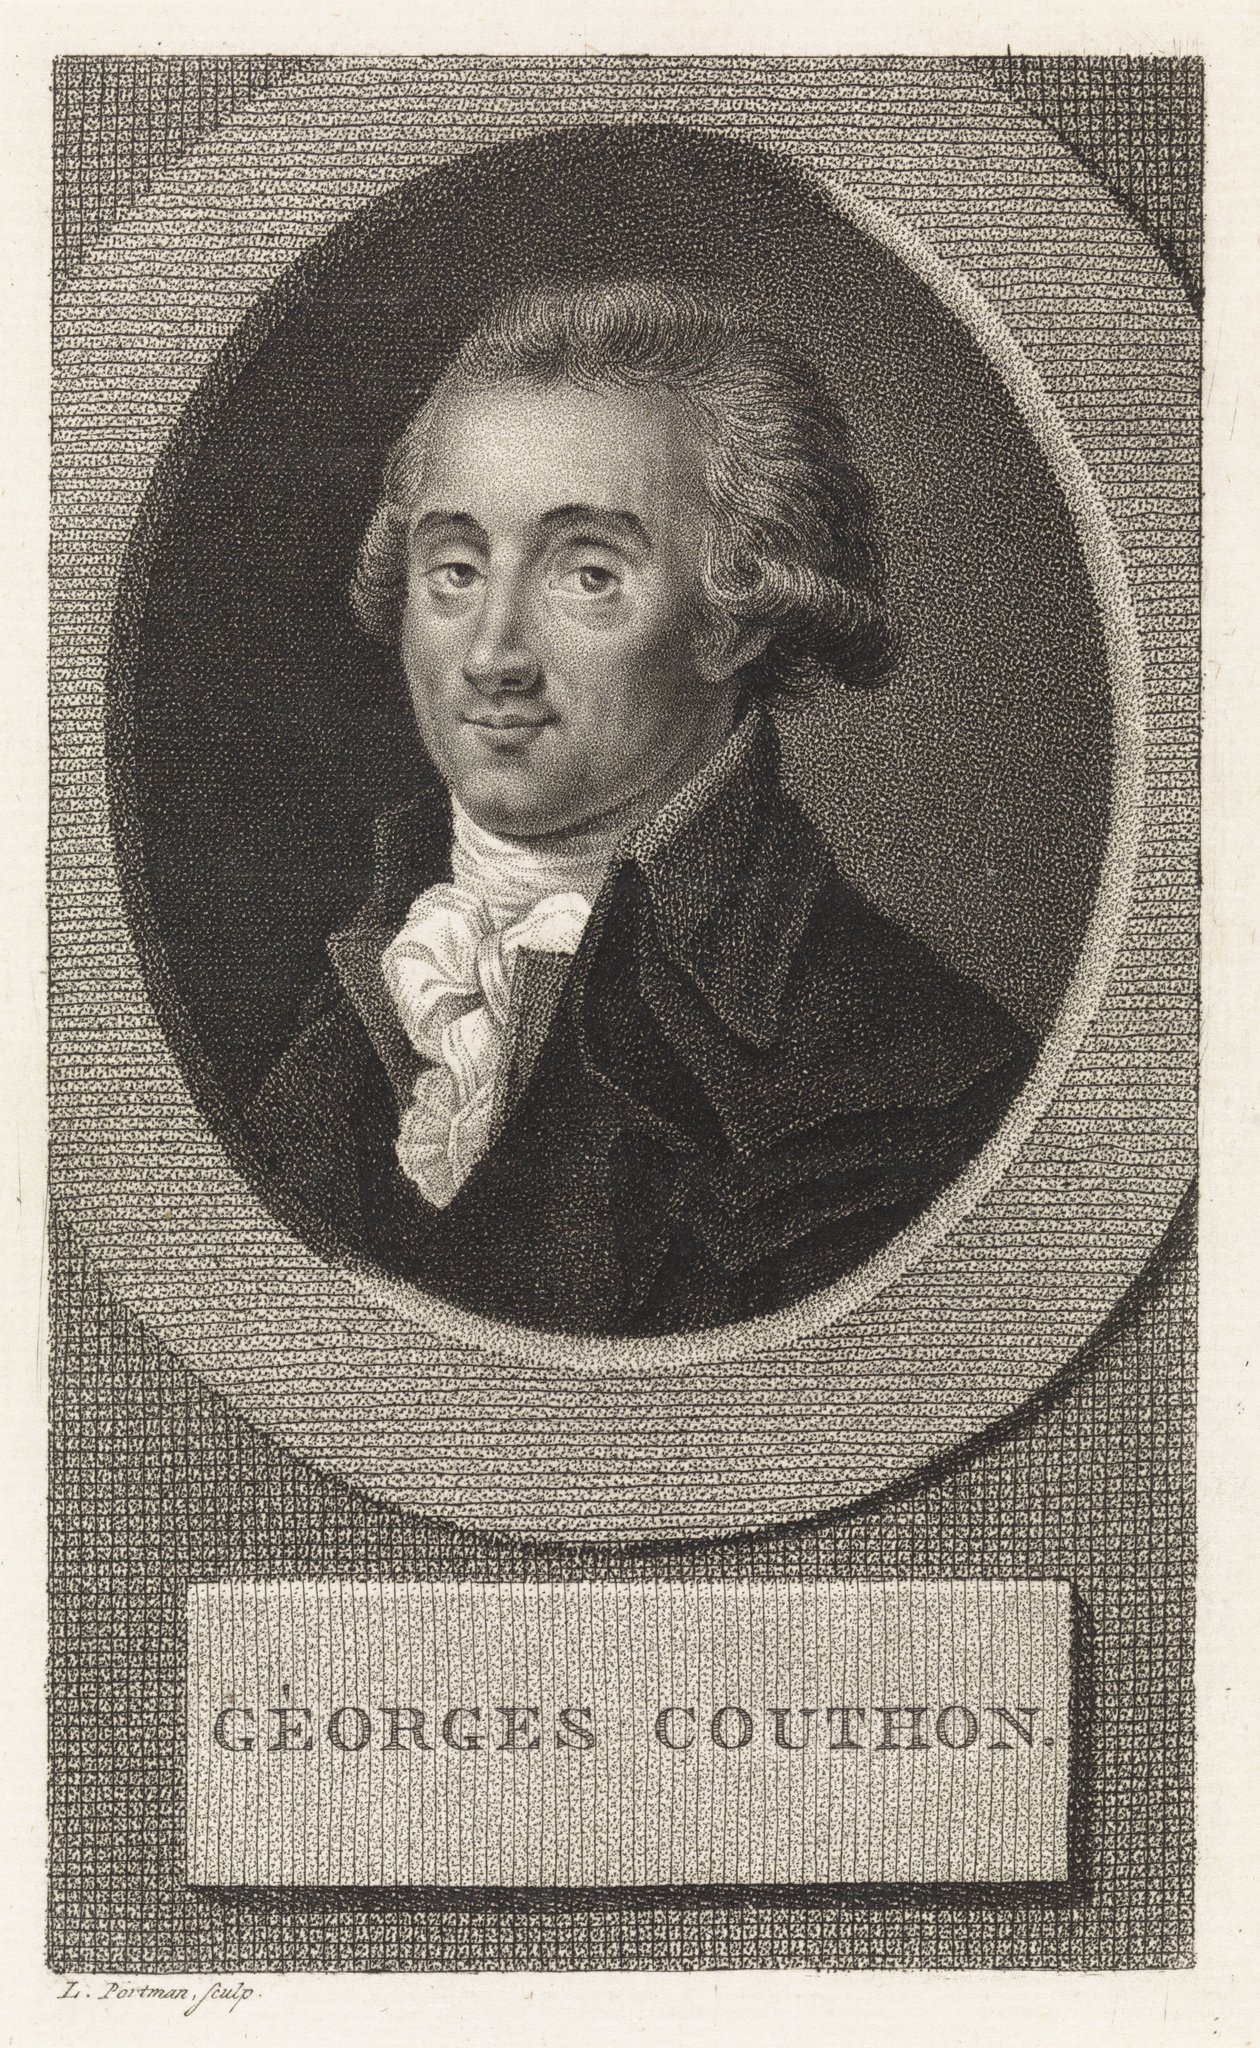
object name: print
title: Portret van Georges Auguste Couthon, Franse politicus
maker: ludwig gottlieb portman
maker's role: print maker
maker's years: 1772-1828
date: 1804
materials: paper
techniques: stippled etching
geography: amsterdam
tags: advocaat, georges auguste couthon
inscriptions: collector's mark: Lugt 2228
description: Prent ook gebruikt als illustratie in: Tafereelen van de staatsomwenteling in Frankrijk, deel 18, p. 168. Amsterdam: Johannes Allart, 1804.